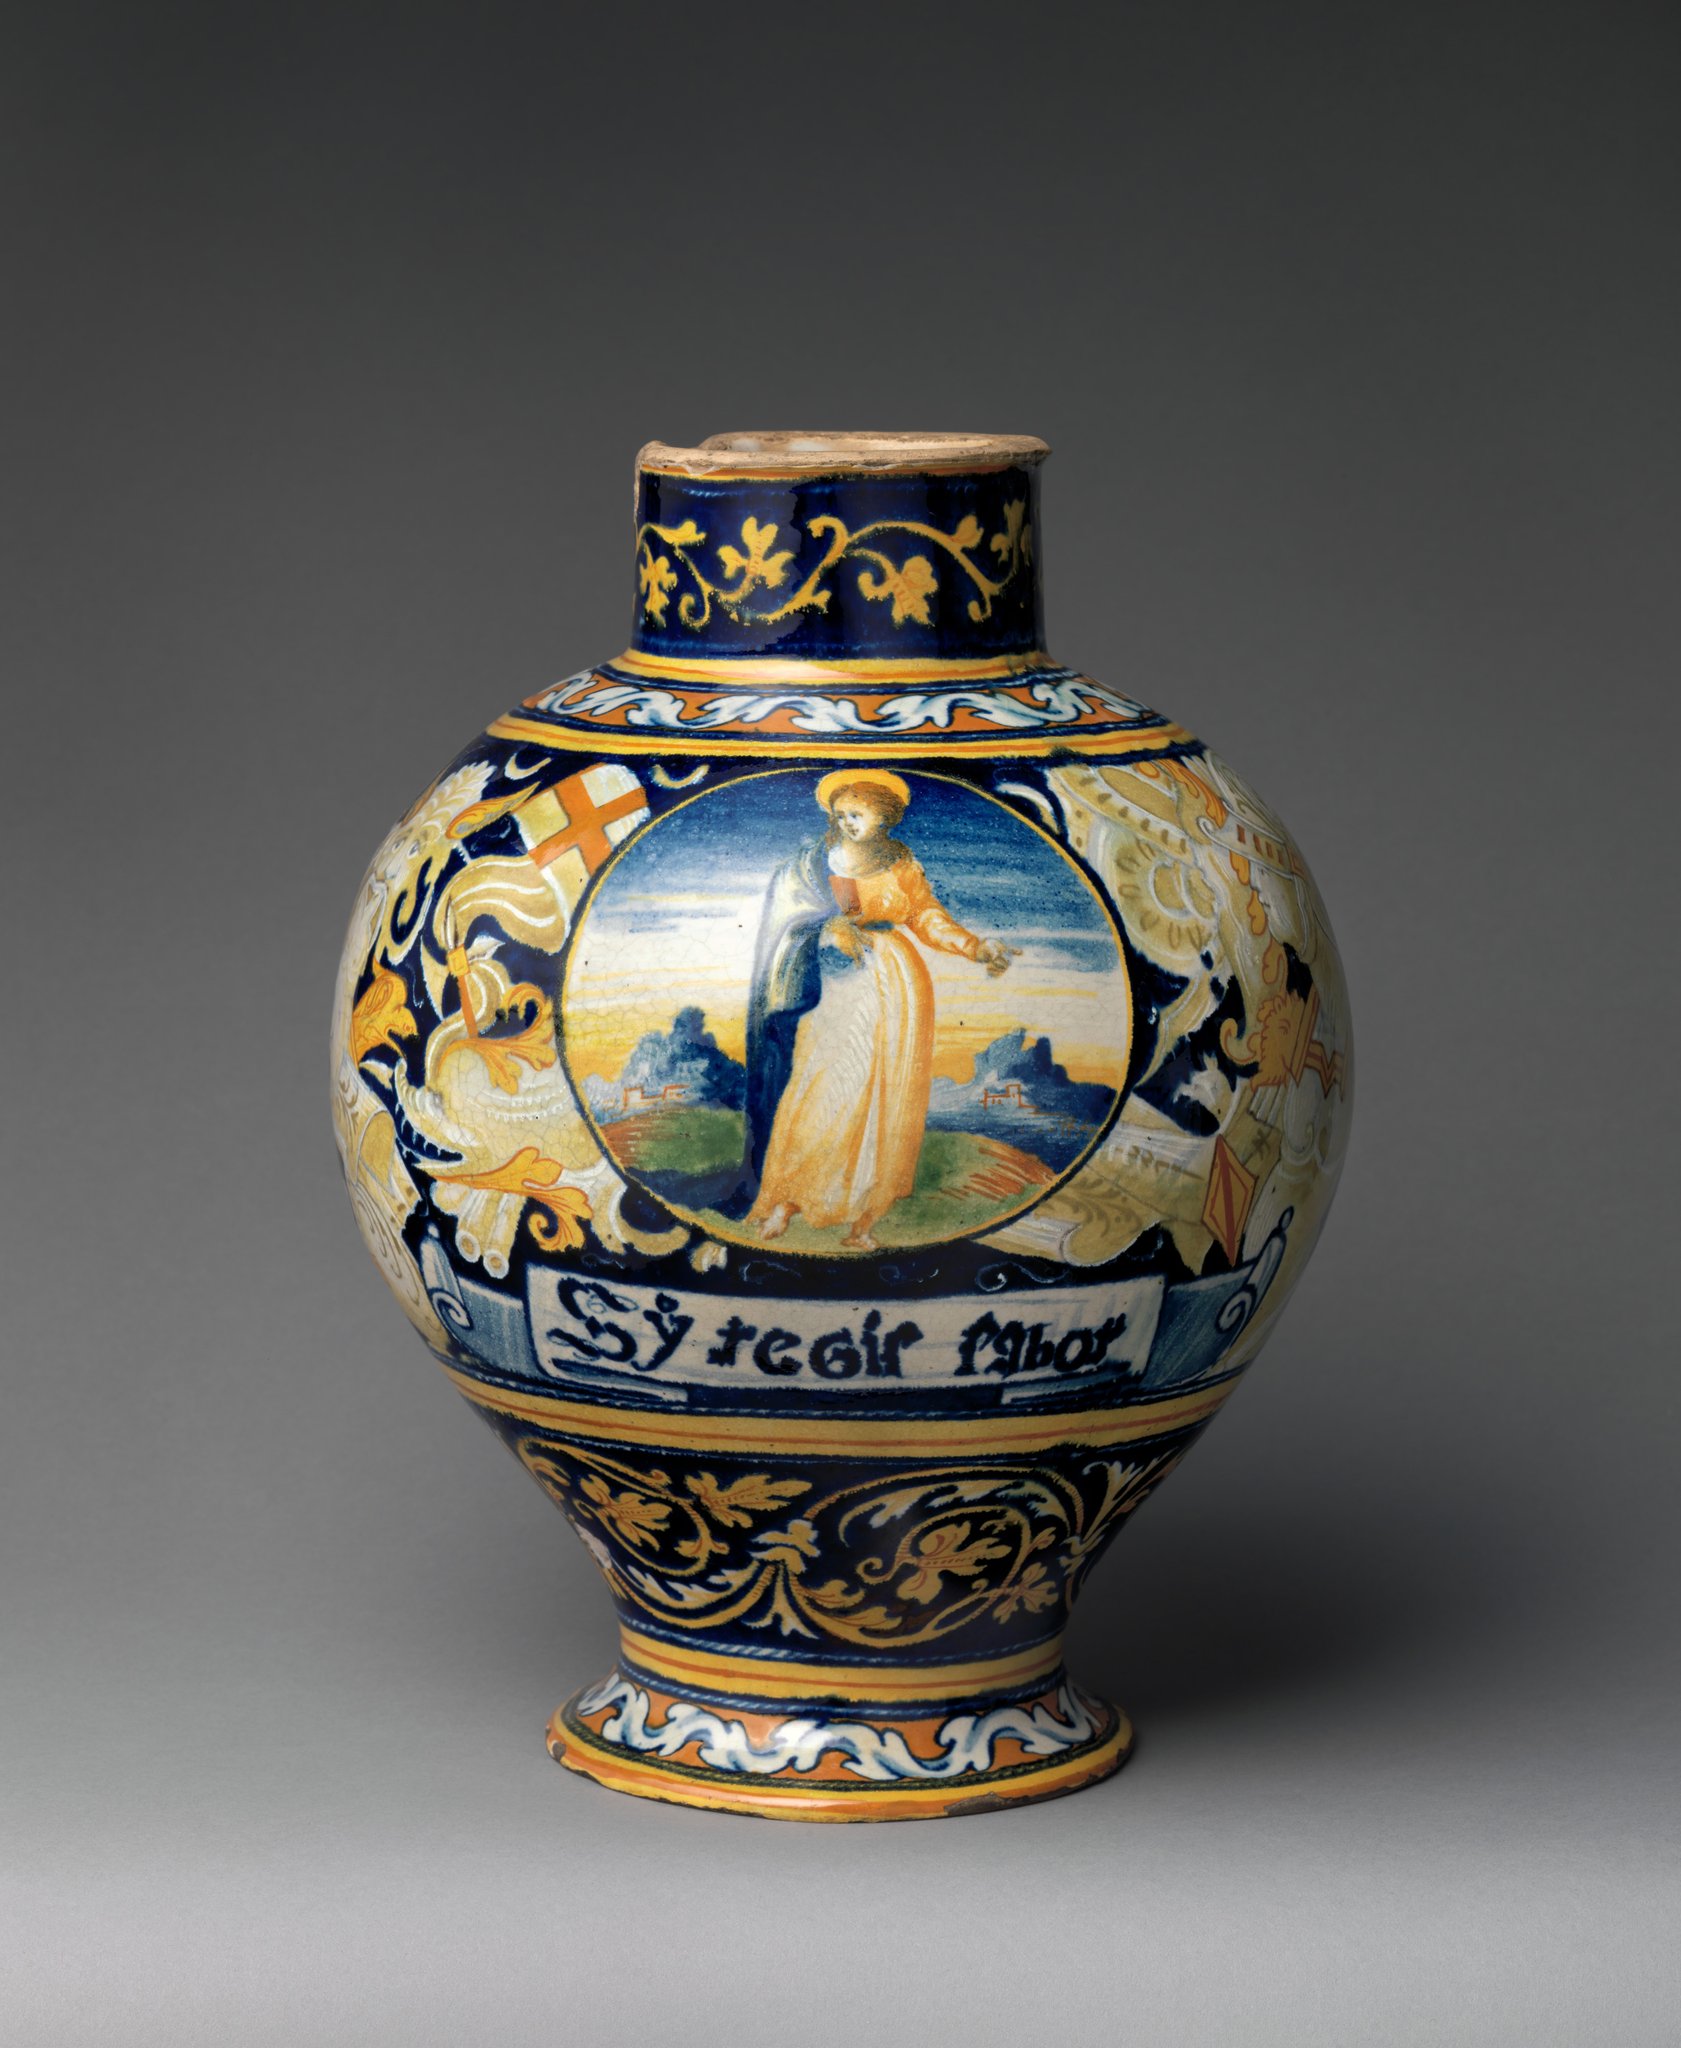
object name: vase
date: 1801-1900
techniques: maiolica, glazing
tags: women